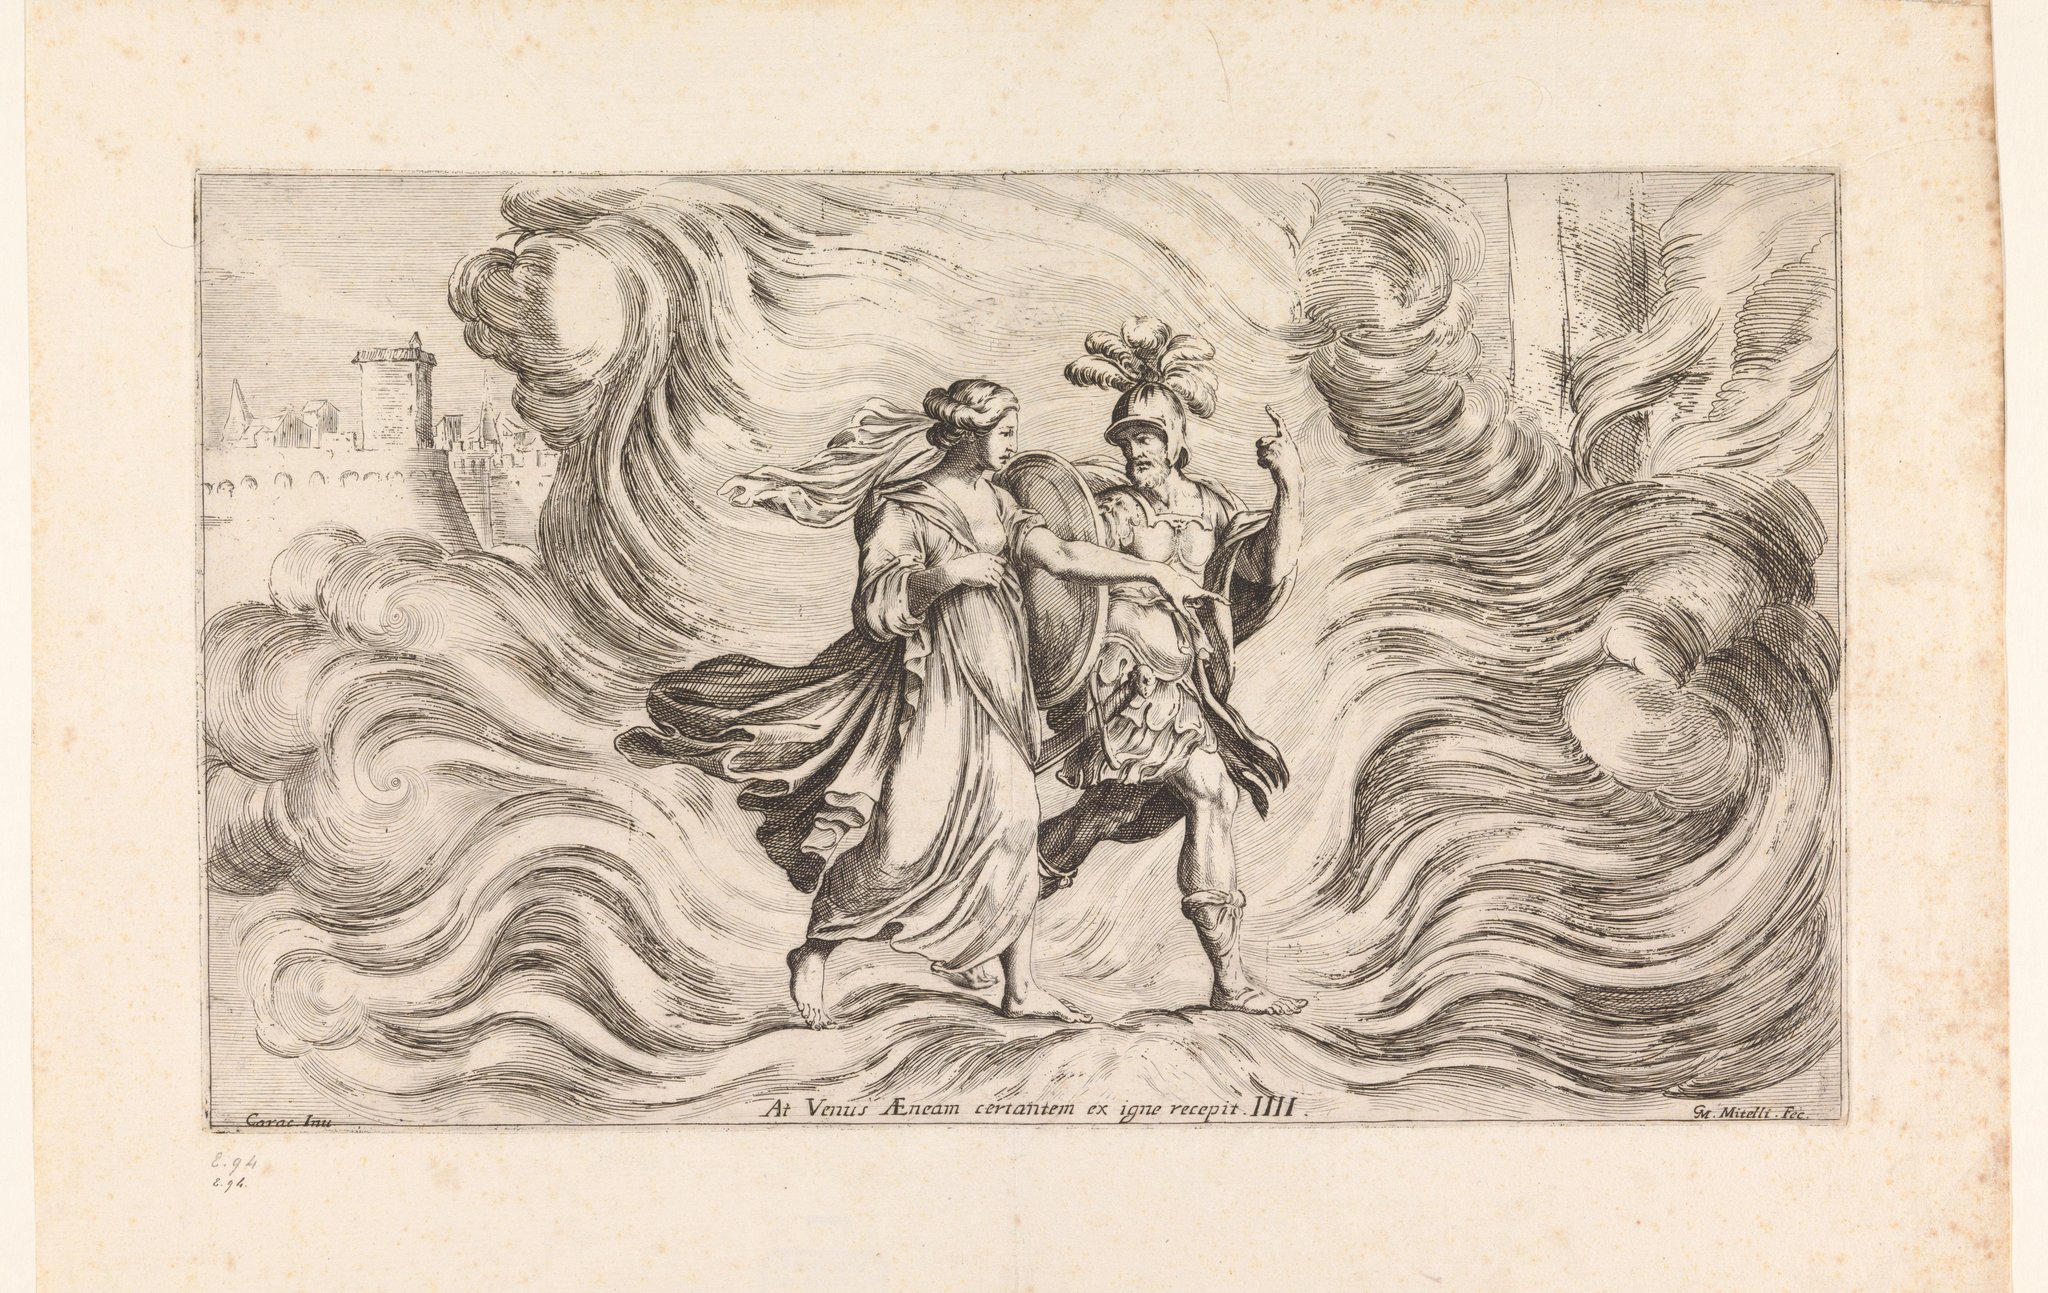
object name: print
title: L'Enea Vagante pitture dei Caracci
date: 1663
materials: paper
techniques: etching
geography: italy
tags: (story of) aeneas, (story of) venus (aphrodite)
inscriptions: collector's mark: Lugt 11, collector's mark: ‘Hinloopen’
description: Deze prent maakt deel uit van een reeks van 20 prenten (+ titelprent) naar de fresco's door de Carracci's in Palazzo Fava Ghisilieri te Bologna. Deze prent maakte oorspronkelijk deel uit van liber nr. 22 van de Atlas van Rome, uit de collectie Hinloopen. In dit album waren een aantal prentreeksen naar bekende zeventiende eeuwse frescoseries bijeengebonden. In 1709 heeft Schijnvoet op last van de burgemeesters van Amsterdam de collectie herordend. De prenten uit liber 22 kwamen terrecht in Schijnvoet boek nr. 10. De laatst gedateerde reeks in het album is gedateerd 1691. Het album moet dus na deze datum gebonden zijn. De band is in de Rijksakademietijd uit elkaar gehaald. De marges van de prenten zijn bij het opbergen in het Rijksprentenkabinet vaak drastisch afgesneden. Van een aantal series waren de prenten teruggeslagen om in het album te passen. (Zie: Waals, Jan van der. De prentschat van Michiel Hinloopen. 's-Gravenhage: SDU uitgeverij, 1988, pp. 173-174.)